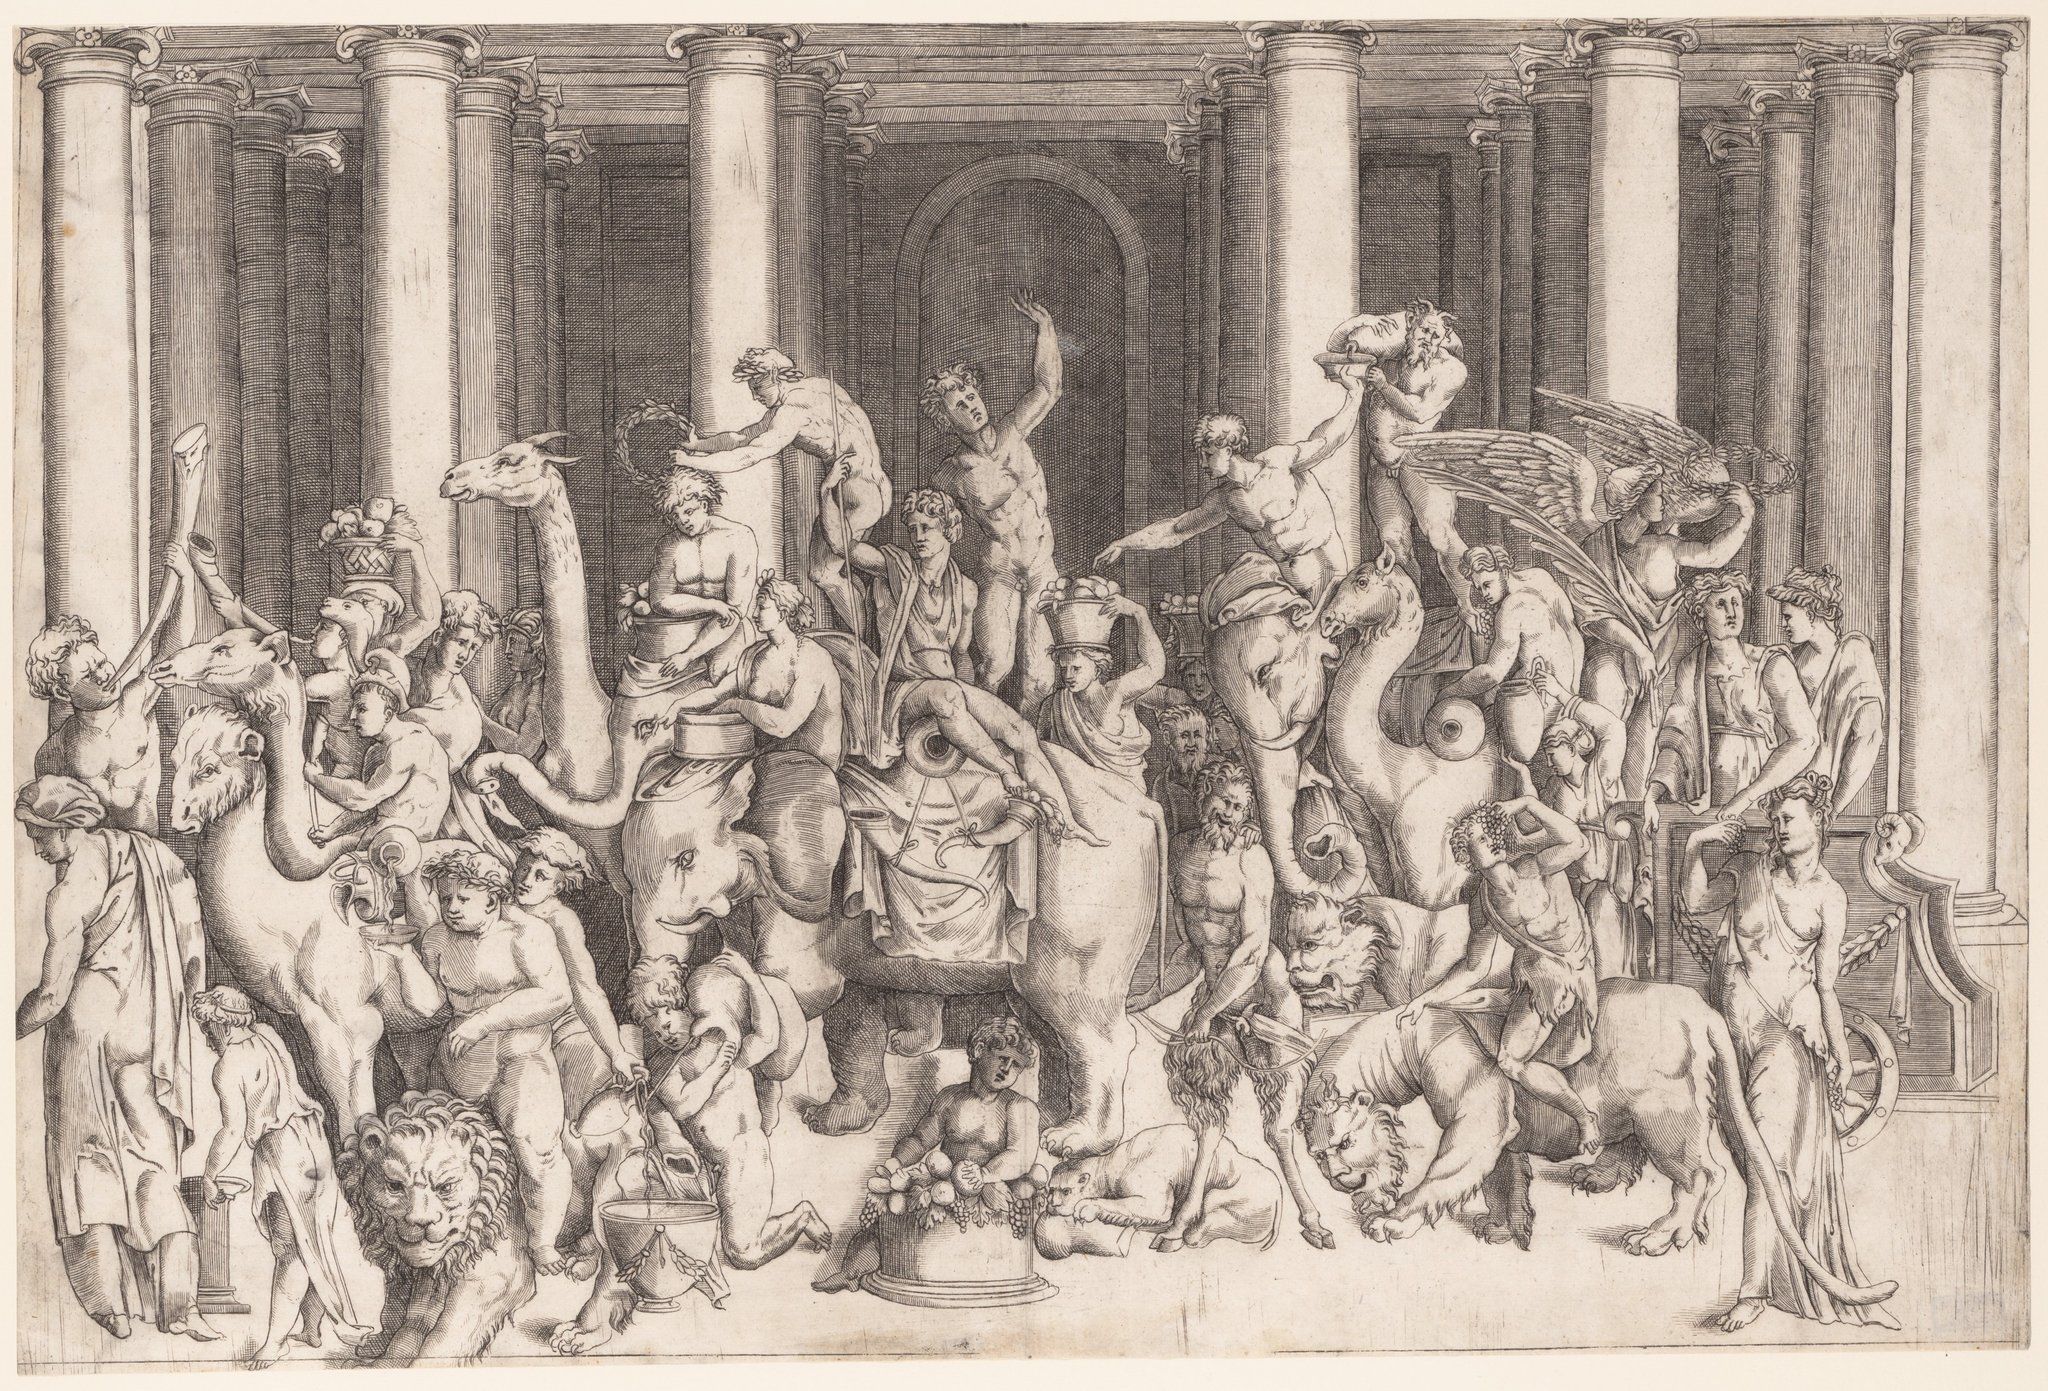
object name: print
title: The Indian Triumph of Bacchus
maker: enea vico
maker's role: artist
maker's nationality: italian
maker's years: 1523-1567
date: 1542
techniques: engraving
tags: animals,bacchus,elephants,lions